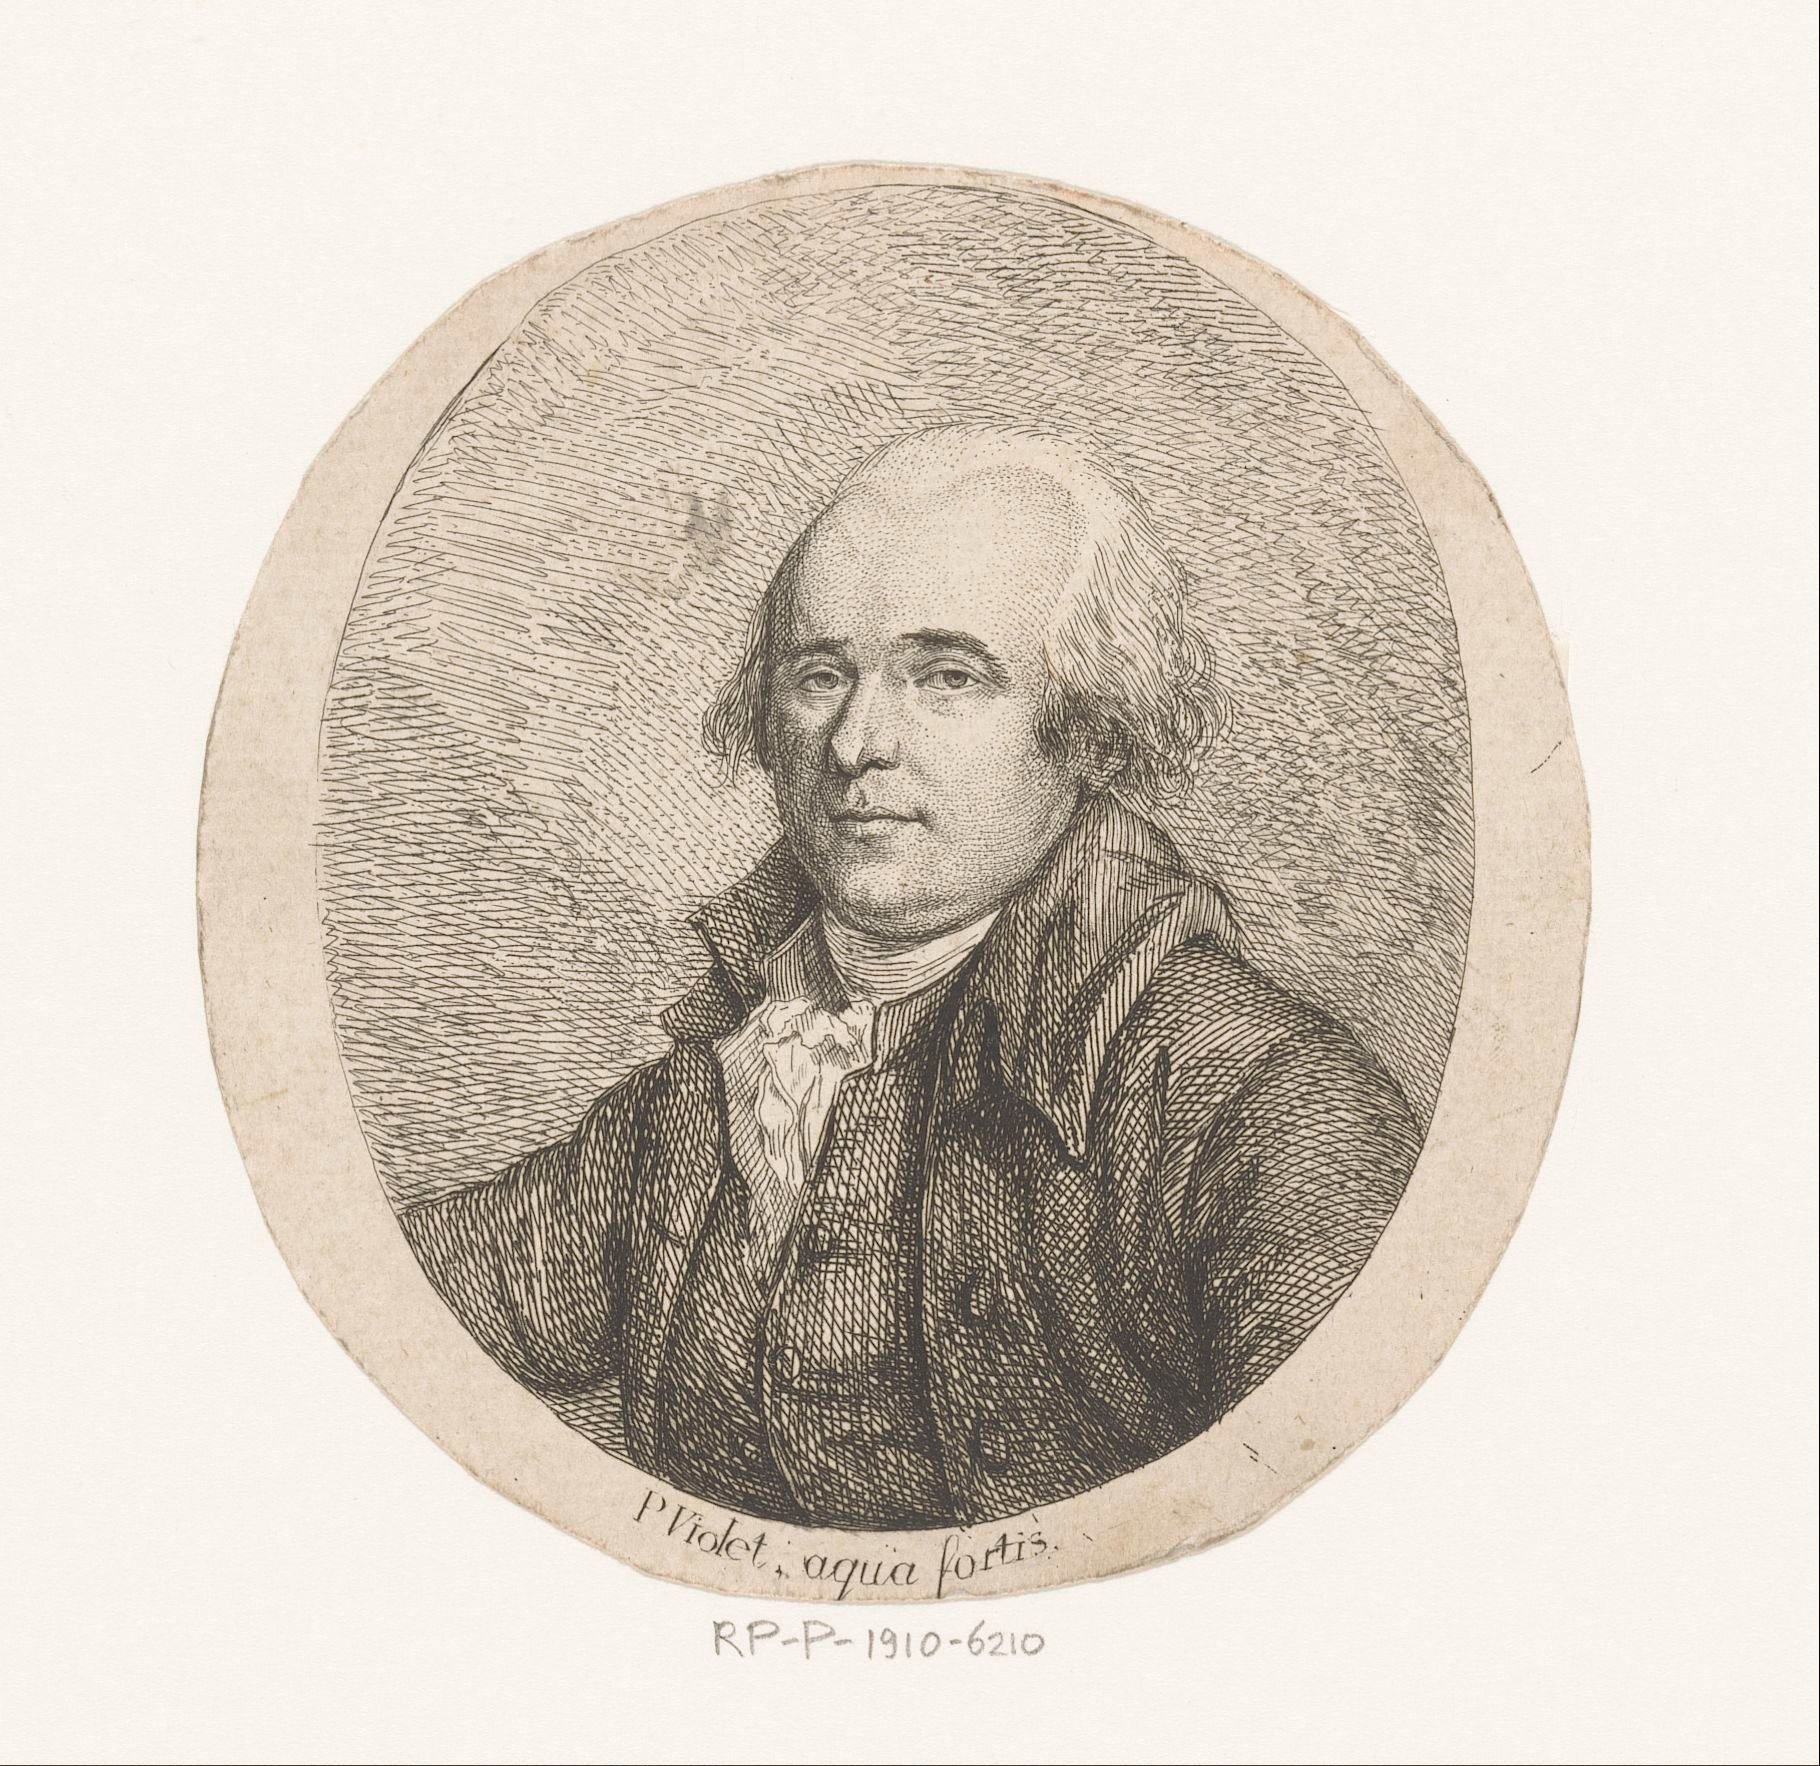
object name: print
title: Portret van een onbekende man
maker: pierre noël violet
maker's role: print maker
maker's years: 1749-1819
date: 1759-1819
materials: paper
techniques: etching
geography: london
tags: historical persons, adult man (+ front view)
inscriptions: collector's mark: Lugt 2228, inscription: ‘van G.L.’